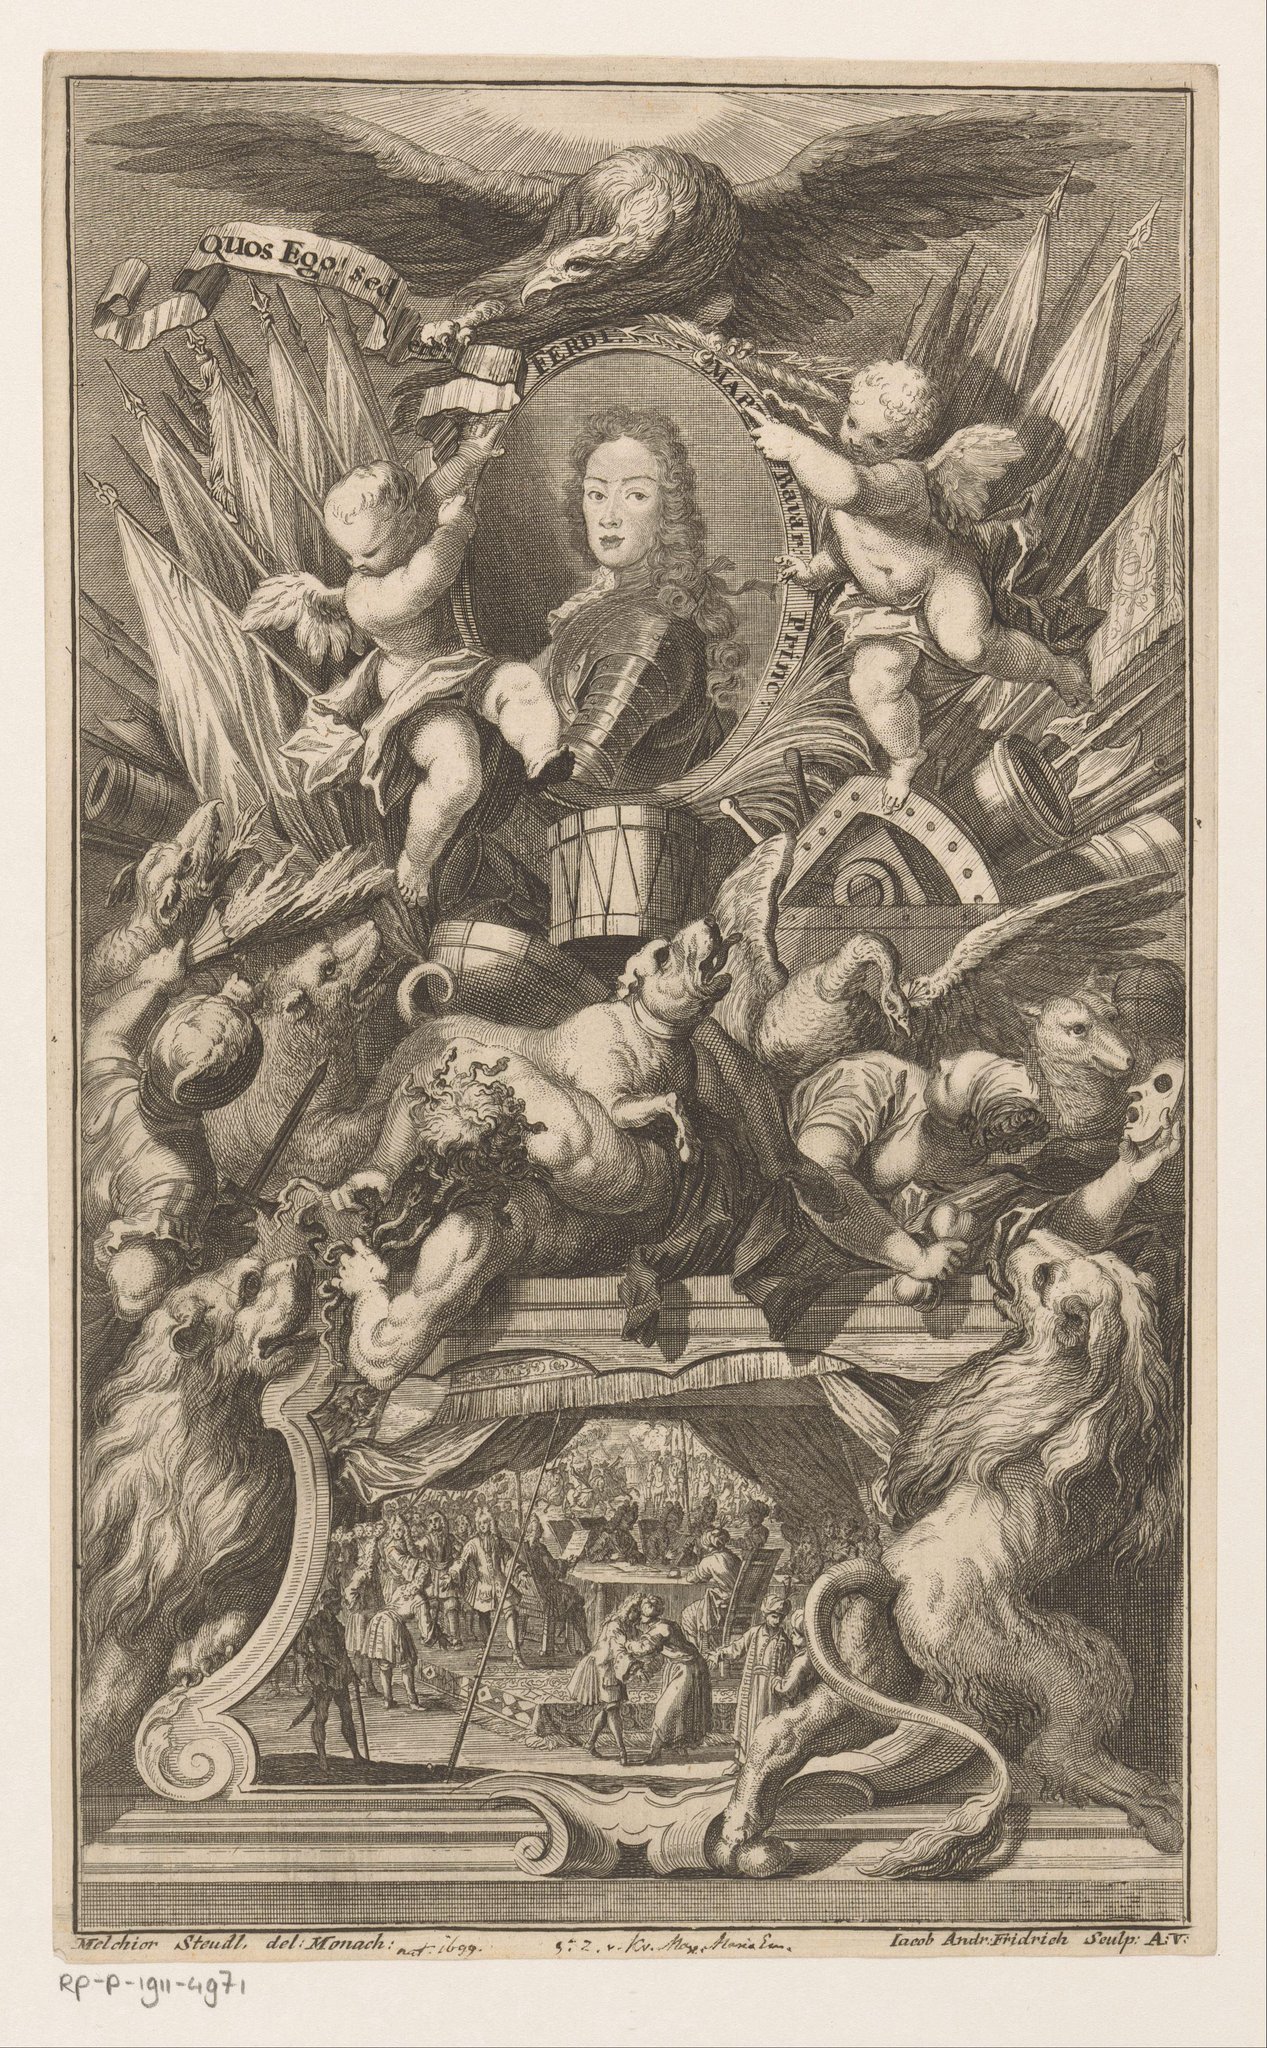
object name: print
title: Portret van Ferdinand van Beieren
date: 1709-1751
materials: paper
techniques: engraving, etching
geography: augsburg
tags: brussels, animals threatening man, ornament ~ medallion, historical persons, medusa (one of the gorgons), symbols, allegories of war; 'guerra' (ripa), attributes of jupiter: eagle, cupids: 'amores', 'amoretti', 'putti'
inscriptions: collector's mark: Lugt 2228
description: Onder in het cartouche een voorstelling van het vredesverbond dat werd gesloten met het Ottomaanse leger.